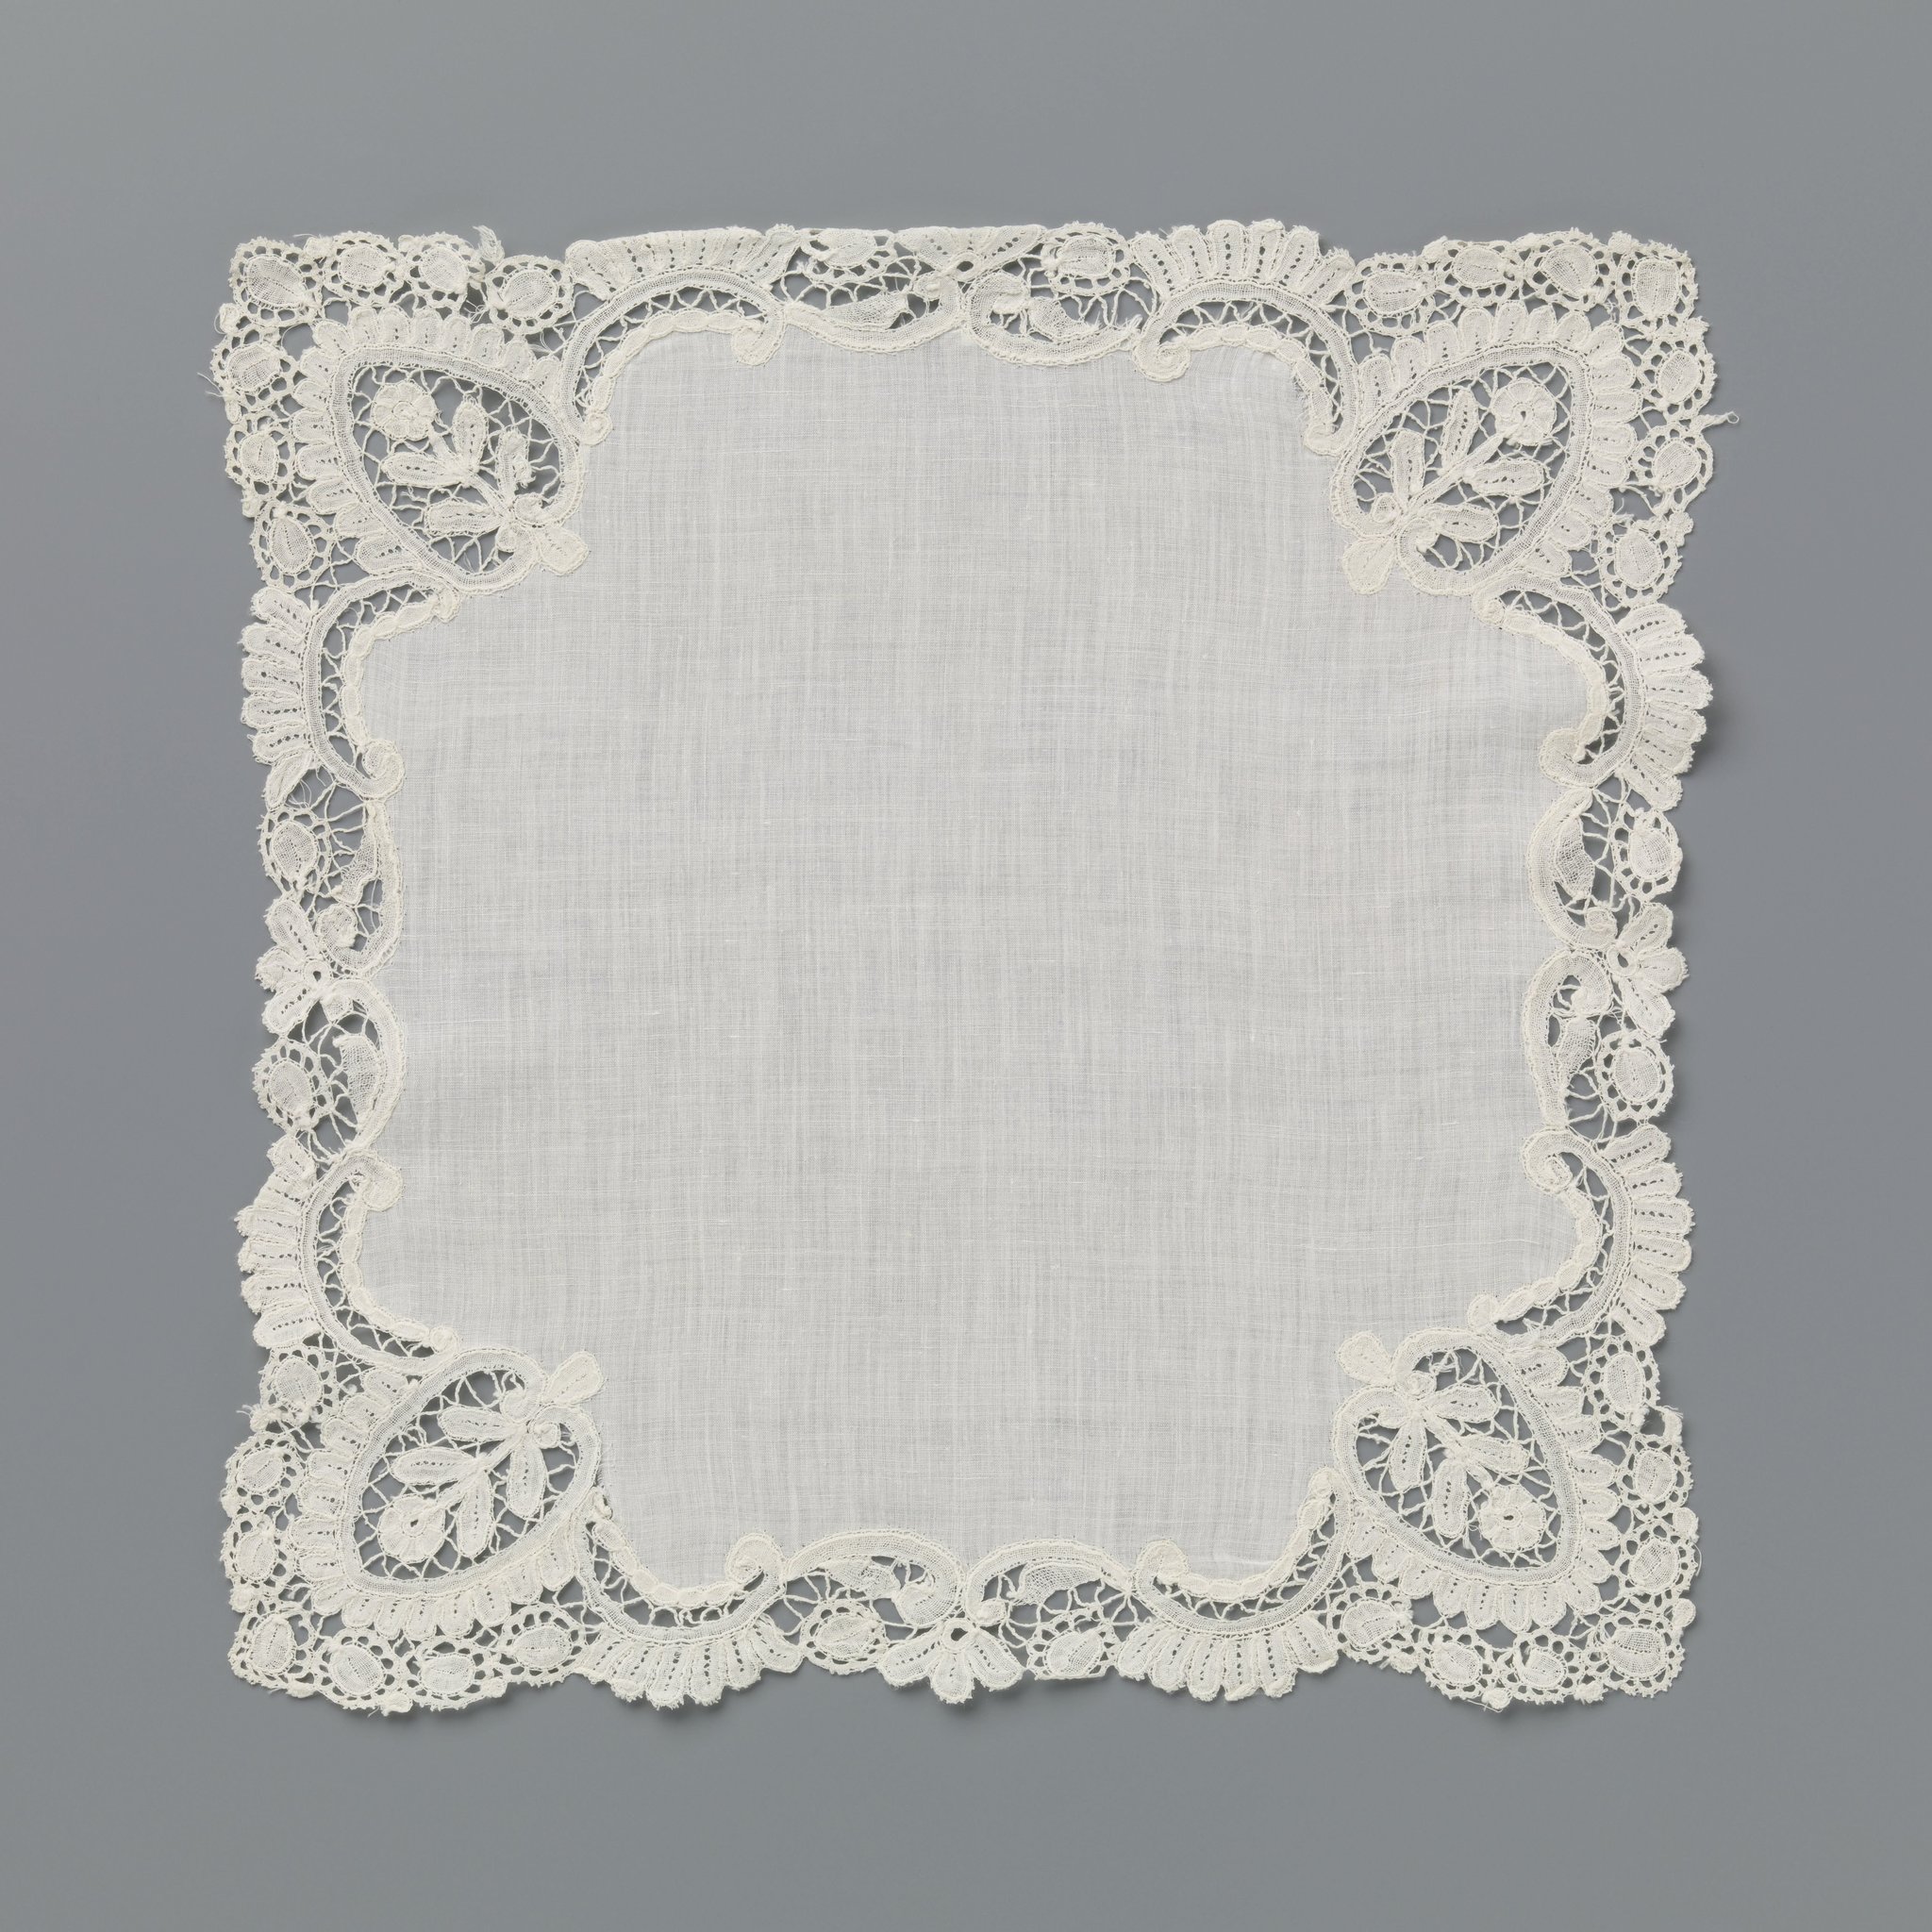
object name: handkerchief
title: Zakdoek van batist rondom afgewerkt met kloskant met in elke hoek een denneappelvormig cartouche met rozetbloempje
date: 1890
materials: textile, cotton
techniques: lace, weave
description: Zakdoek van naturelkleurige batist rondom afgewerkt met naturelkleurige kloskant: fijn Brugs bloemwerk. Symmetrisch patroon met in elke hoek een denneappelvormige cartouche met daarin een rozetbloempje op een lange rechte steel met twee paar ovale bloembladeren. Langs elke zijde vier aan elkaar geschakelde c-voluten met een zigzag-lijn erin. In het midden van elke zijde wordt het raakpunt van twee c-voluten bekroond door een bloem met drie ovale bloembladeren. De bloem wordt geflankeerd door twee ronde bloemen met vele opengewerkte bloemblaadjes, boogjes, rondom. Zeven van deze ronde bloemen met boogjesblaadjes vormen de schulpenrand rond elke hoek om de cartouches heen. De motieven zijn gemaakt in linnenslag met opengewerkte randjes en zijn voorzien van dikke contourlijnen. De nerven van bladeren zijn gemaakt met uitsparingen waarin overstekende paren te zien zijn. De schulpenrand is afgewerkt met picots.